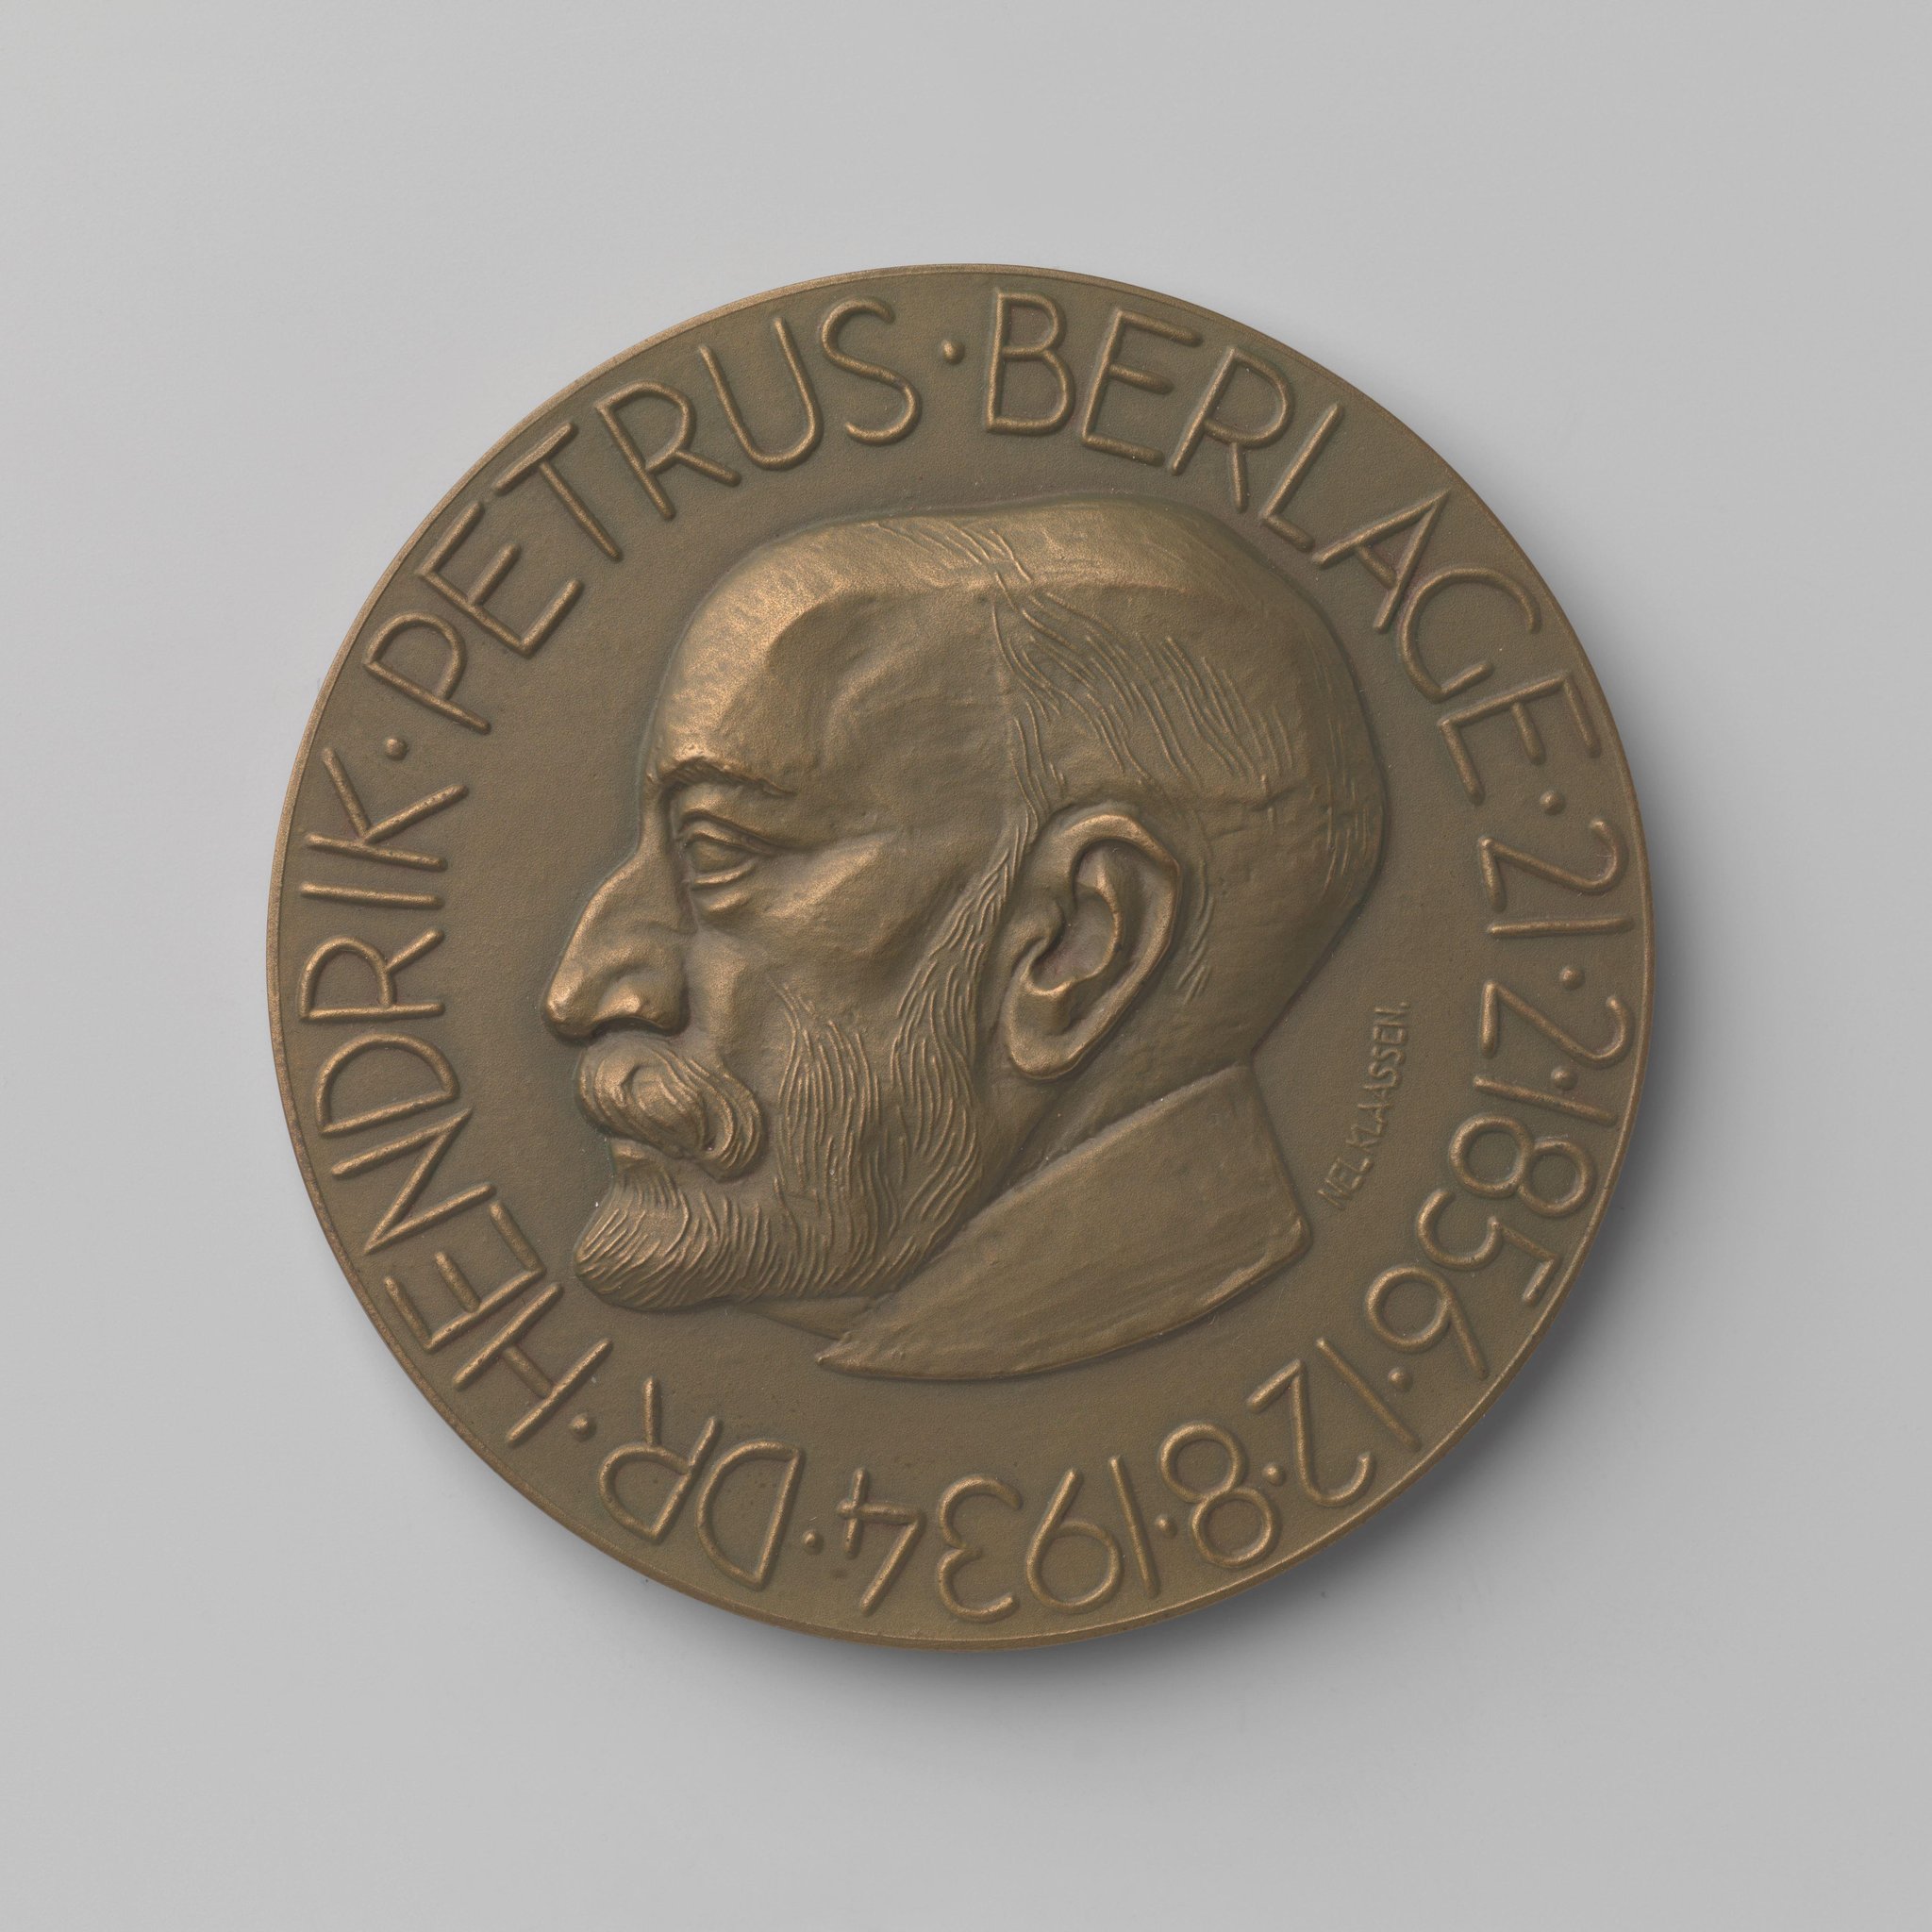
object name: history medal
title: Overlijden van Hendrik Berlage (Vereniging voor Penningkunst 1934, tweede penning)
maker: nel klaassen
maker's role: draughtsman, sculptor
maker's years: 1906-1989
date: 1934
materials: bronze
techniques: striking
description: Bronzen penning, op de voorzijde het portret van Berlage naar links met omschrift, op de eerzijde een gebouw met klokkentoren met onderaan omschrift, met verklaring.